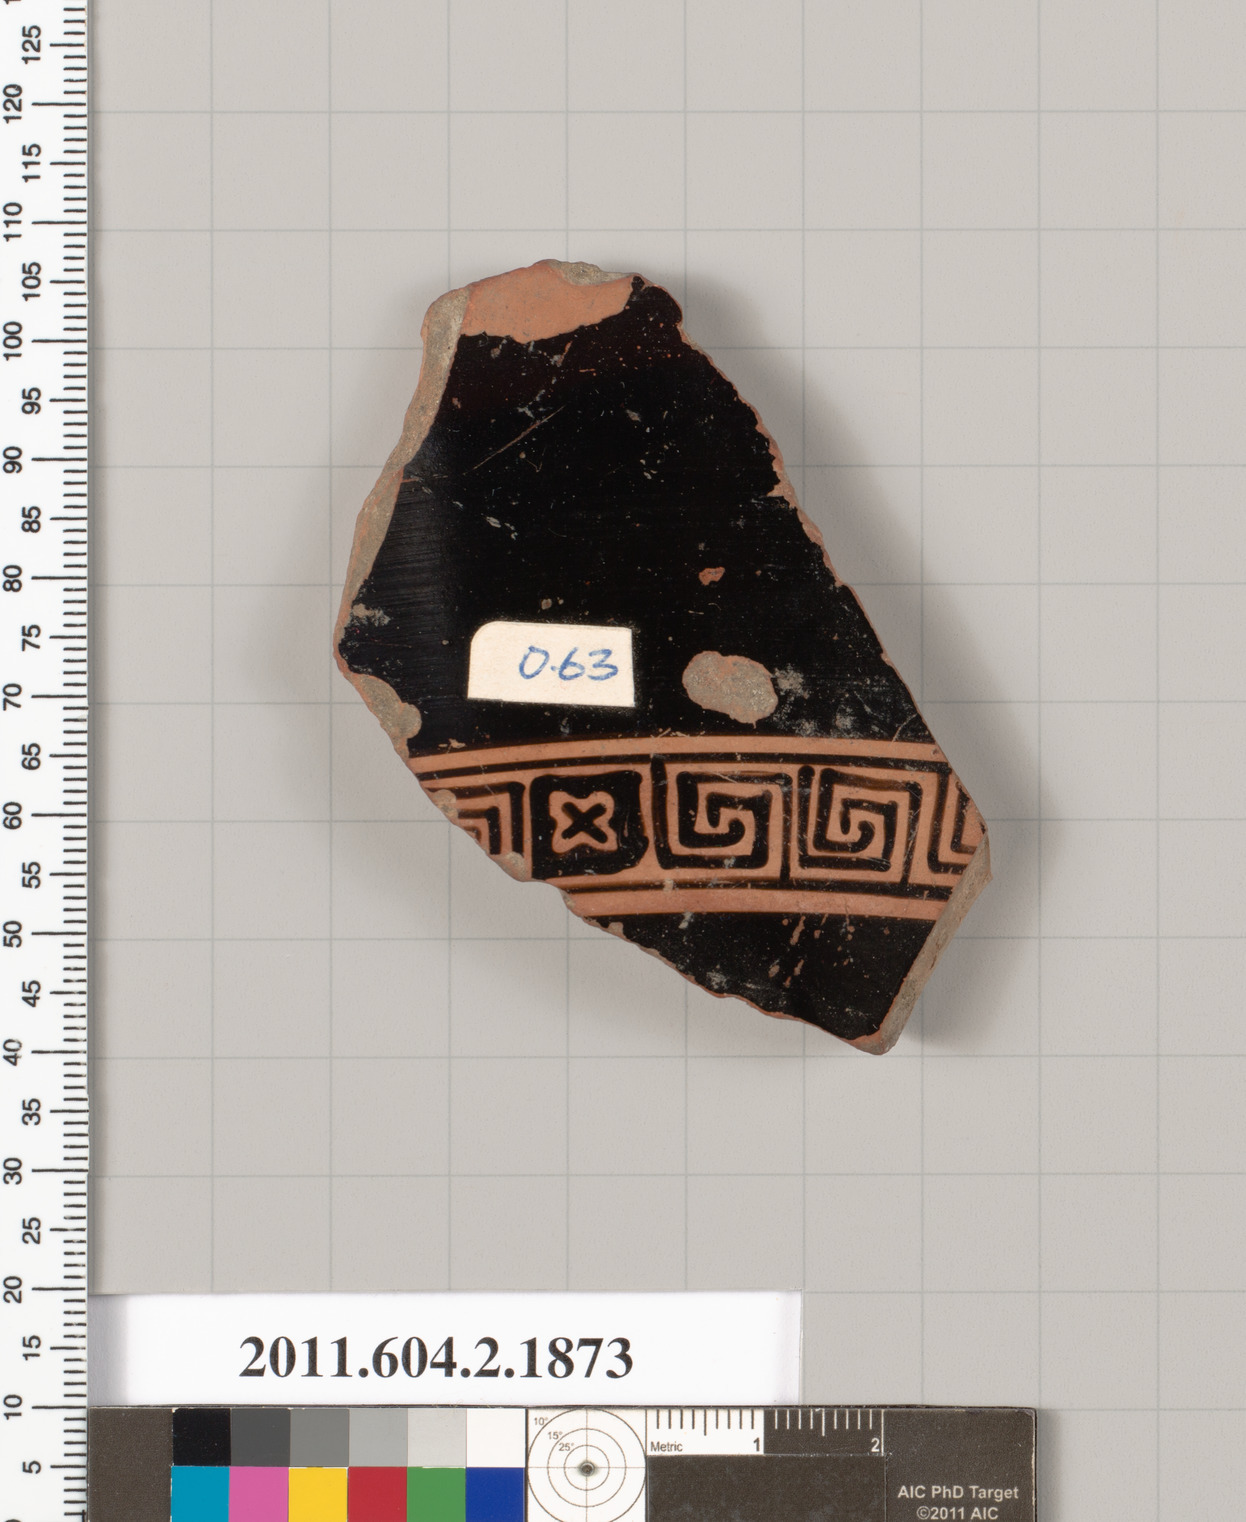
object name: skyphos fragment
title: Terracotta fragment of a skyphos (deep drinking cup)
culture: greek, attic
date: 470-450 BCE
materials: terracotta